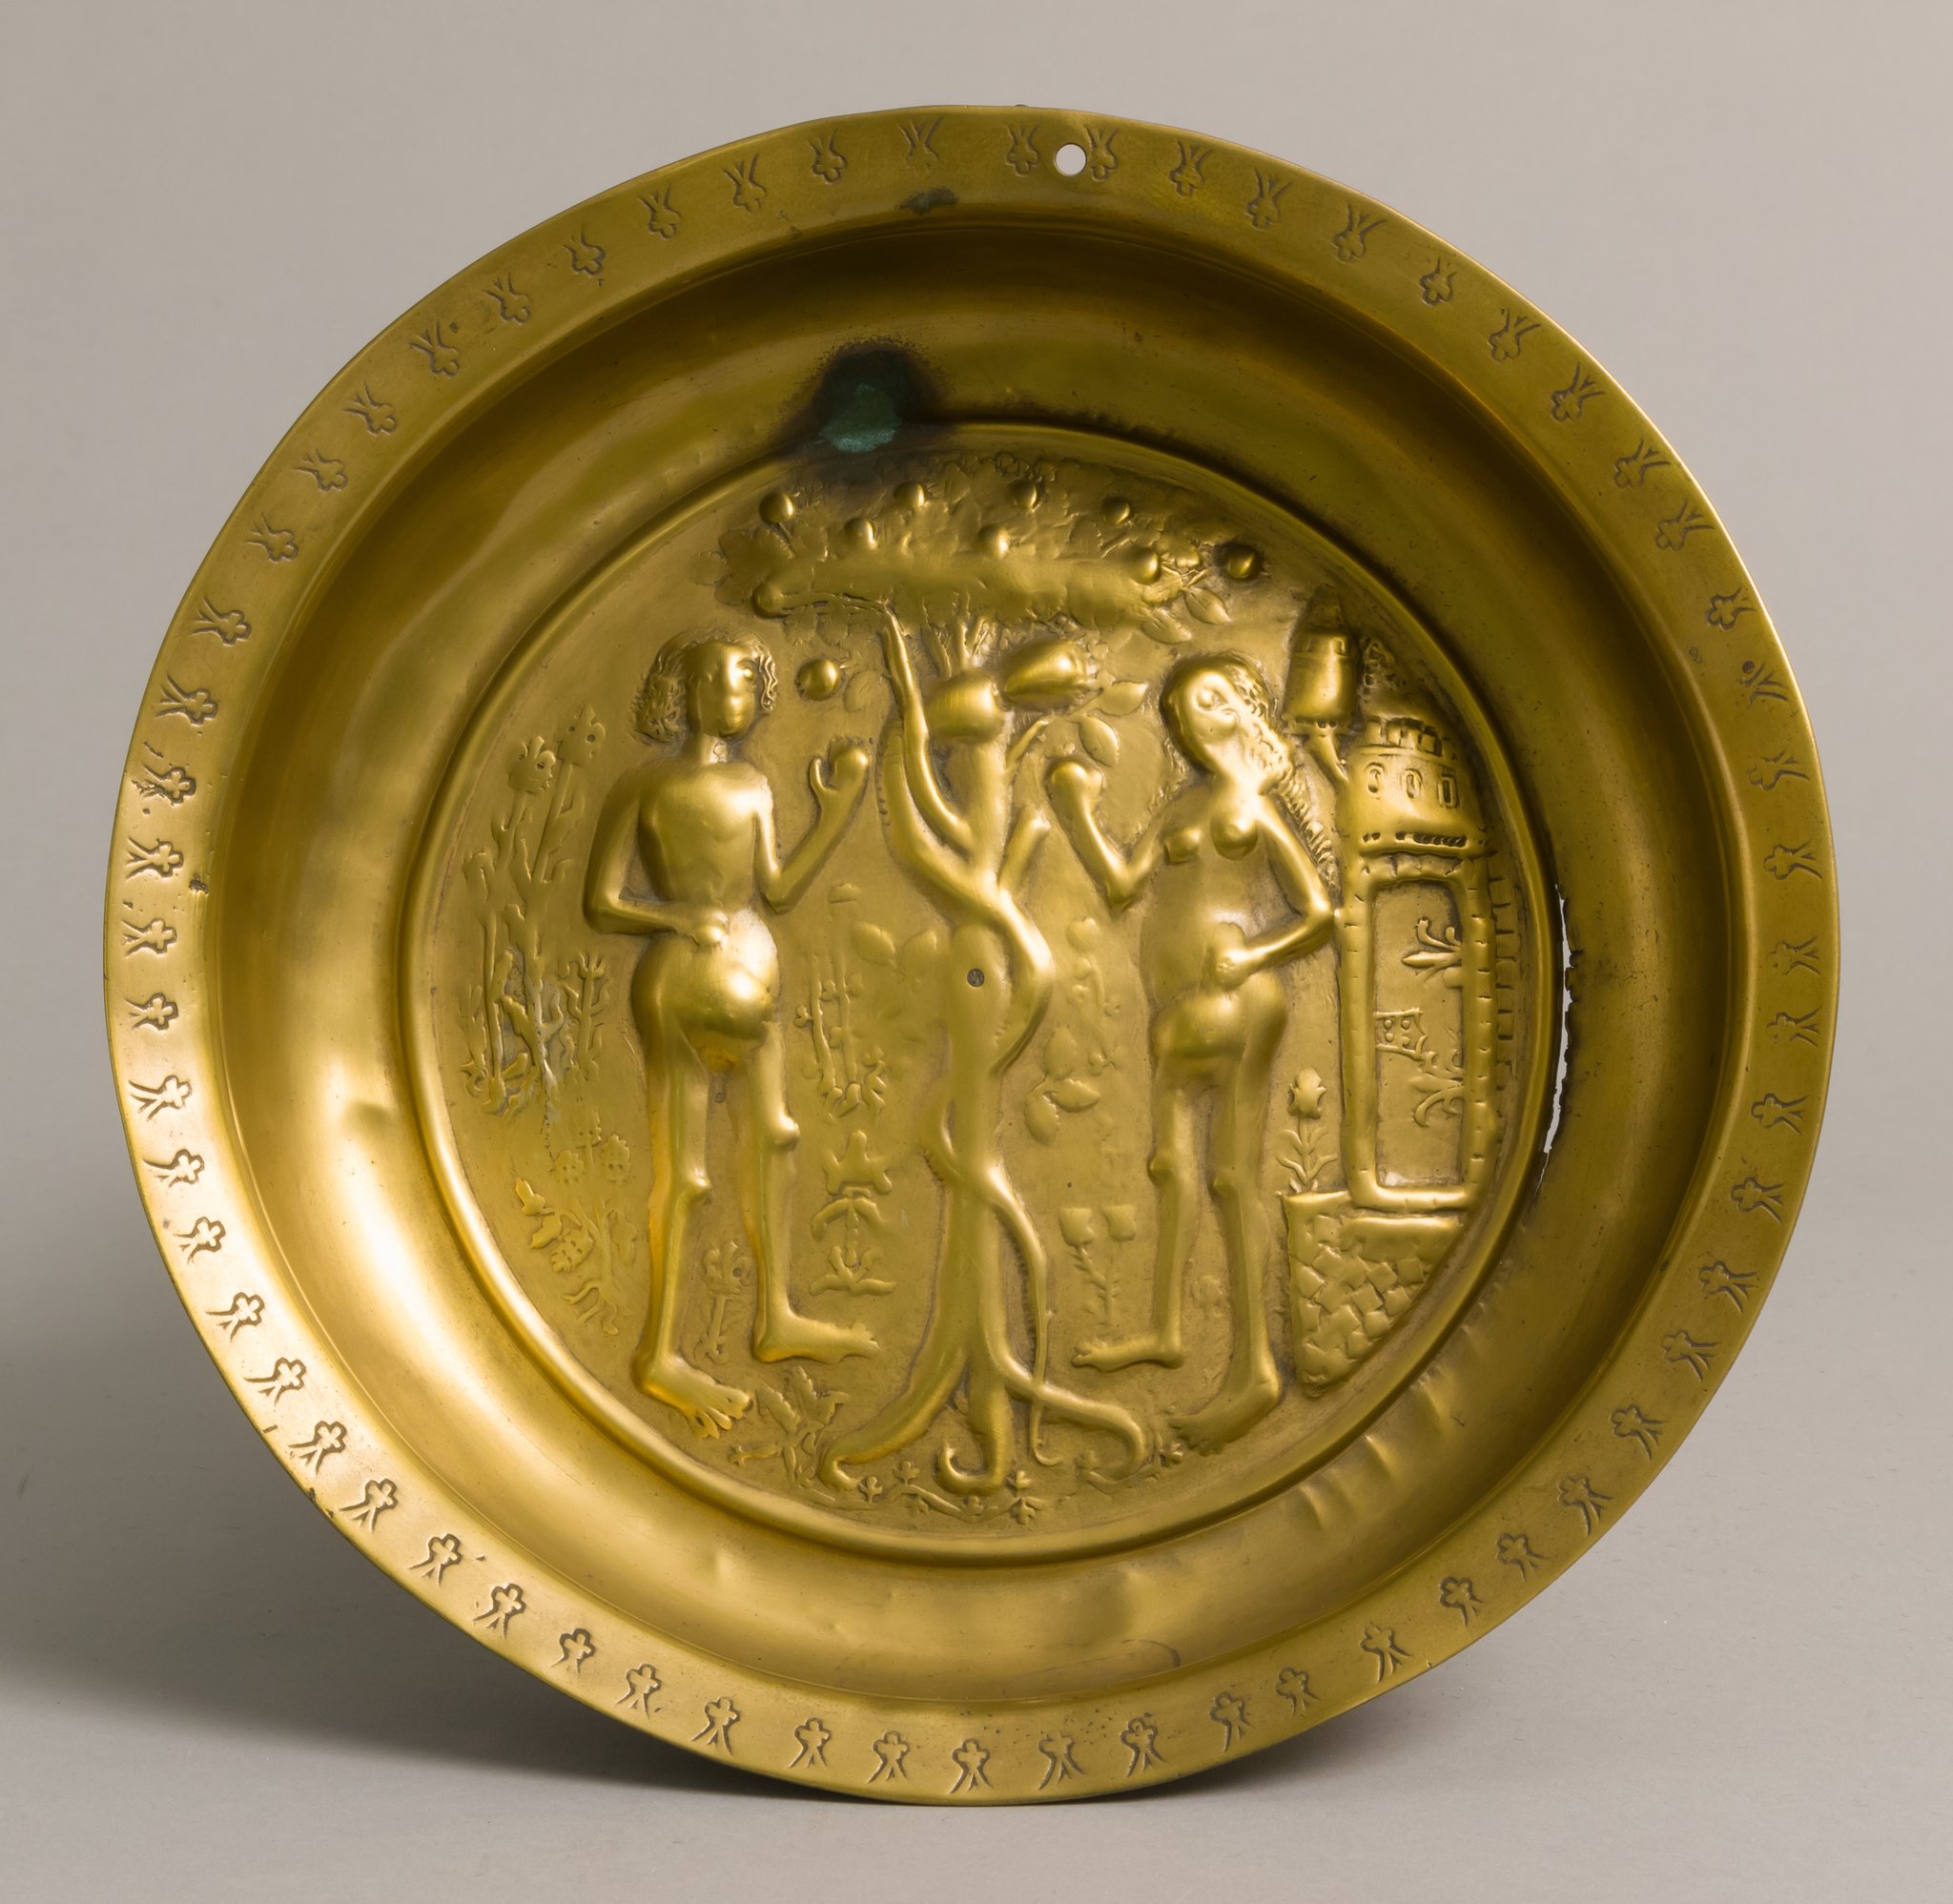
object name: dish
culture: german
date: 1501-1533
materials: brass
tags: human figures